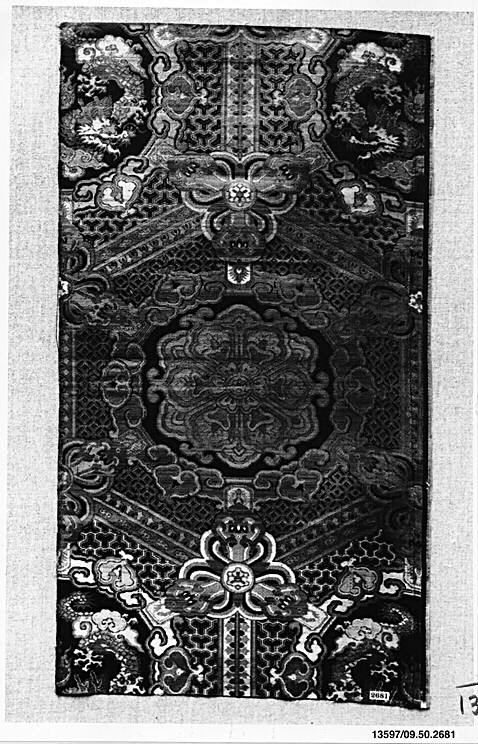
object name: piece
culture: japanese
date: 1801-1900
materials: silk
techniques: brocade